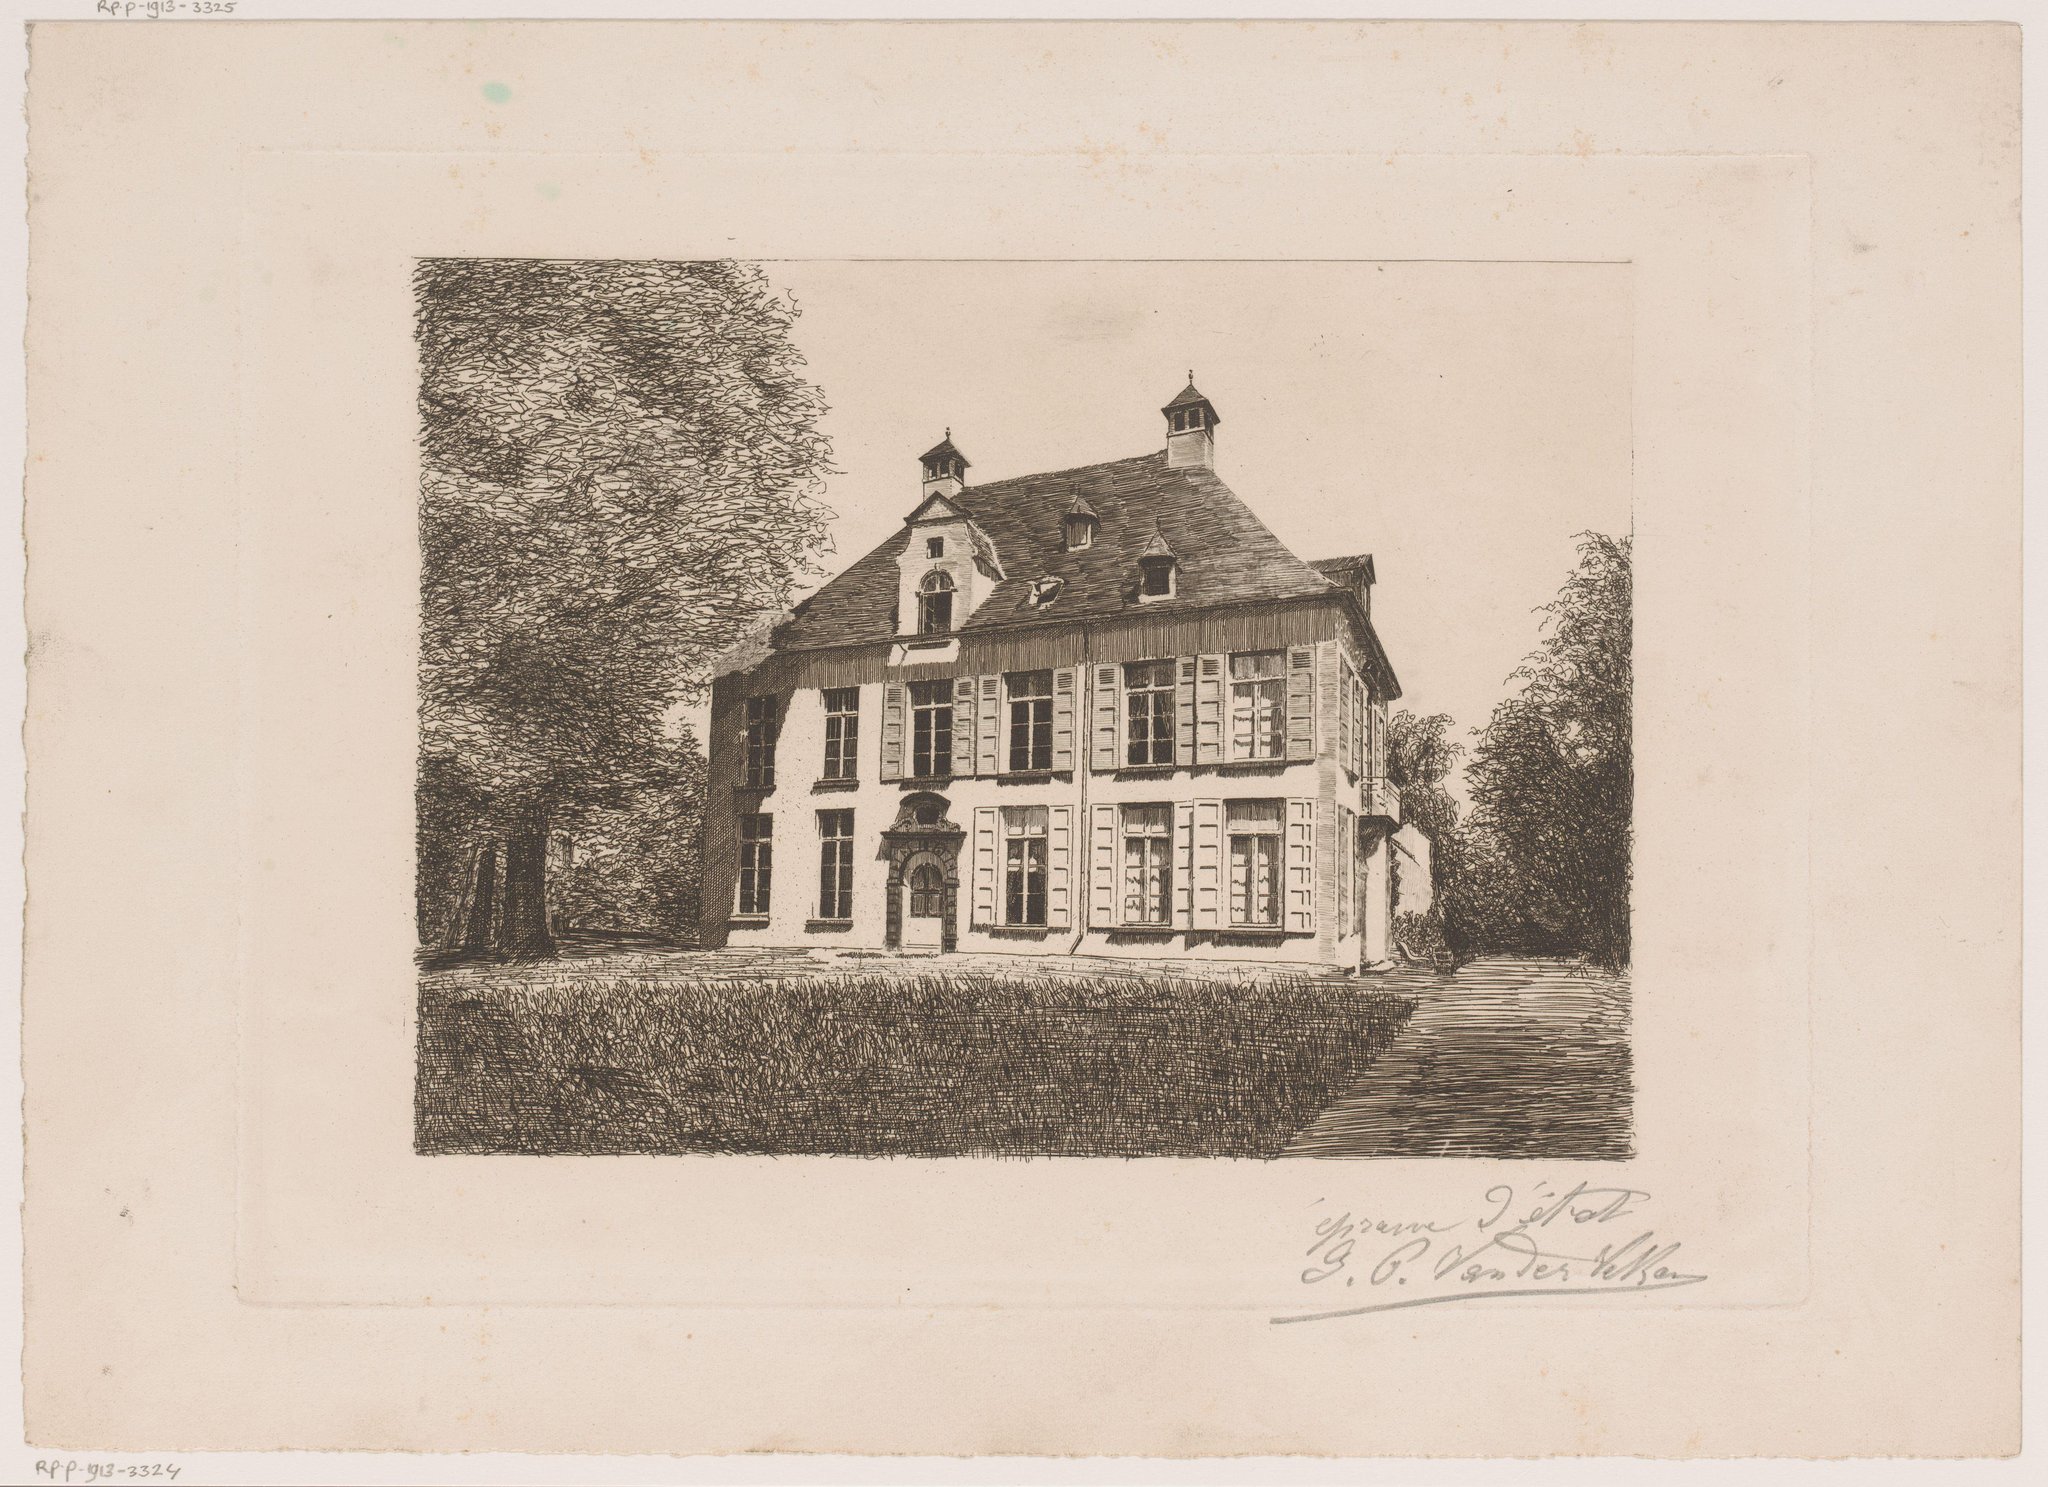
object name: print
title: Gezicht op een buitenplaats, mogelijk te Mortsel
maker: willem philip van der veken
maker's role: print maker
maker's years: 1863-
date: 1873-1913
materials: paper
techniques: etching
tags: rural housing, e.g. country-house, villa, cottage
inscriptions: collector's mark: Lugt 2228, inscription: ‘Epreuve d'état’